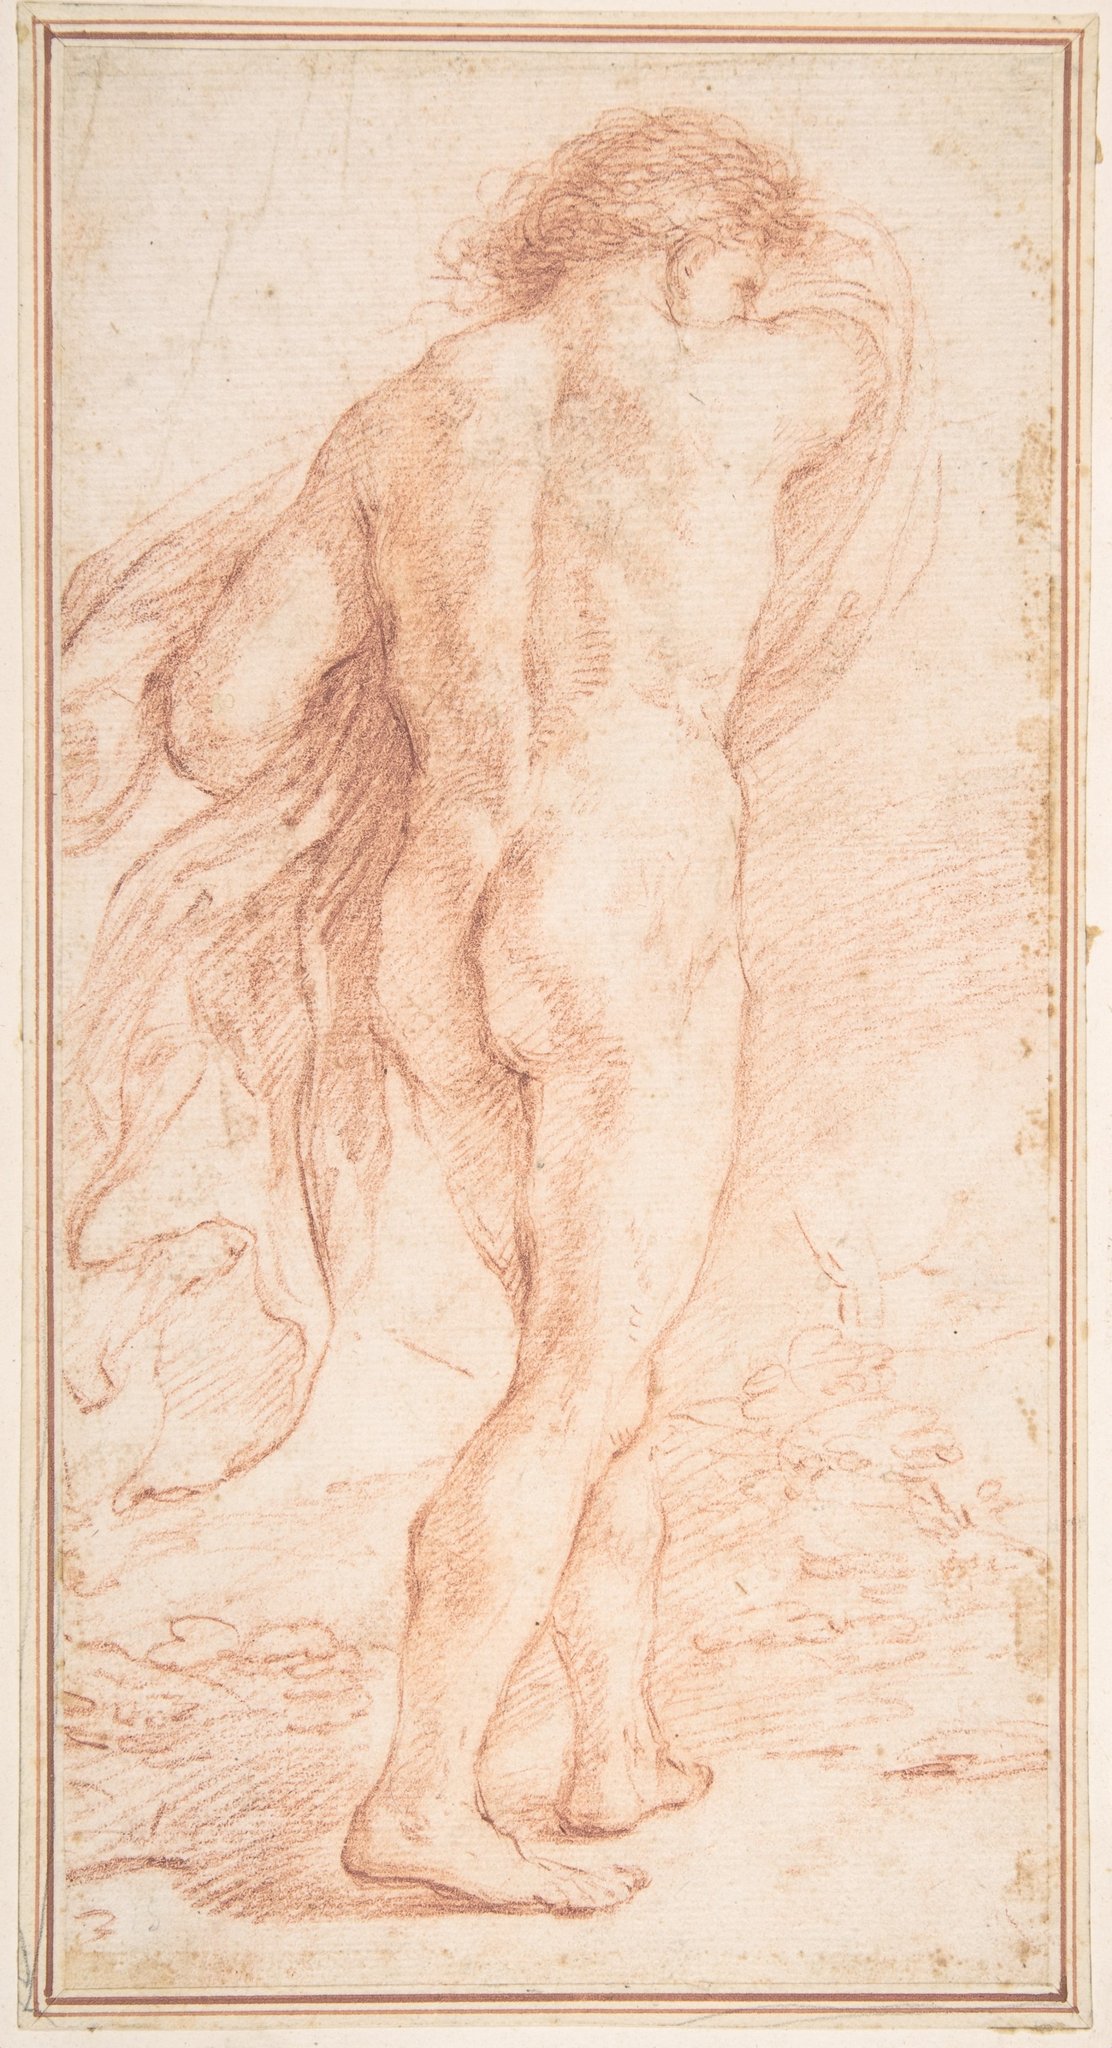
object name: drawing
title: Nude Figure with Cloak, seen from rear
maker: anonymous, italian, roman-bolognese, 17th century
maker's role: artist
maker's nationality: italian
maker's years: 1600-1700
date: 1601-1700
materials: chalk, paper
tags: male nudes